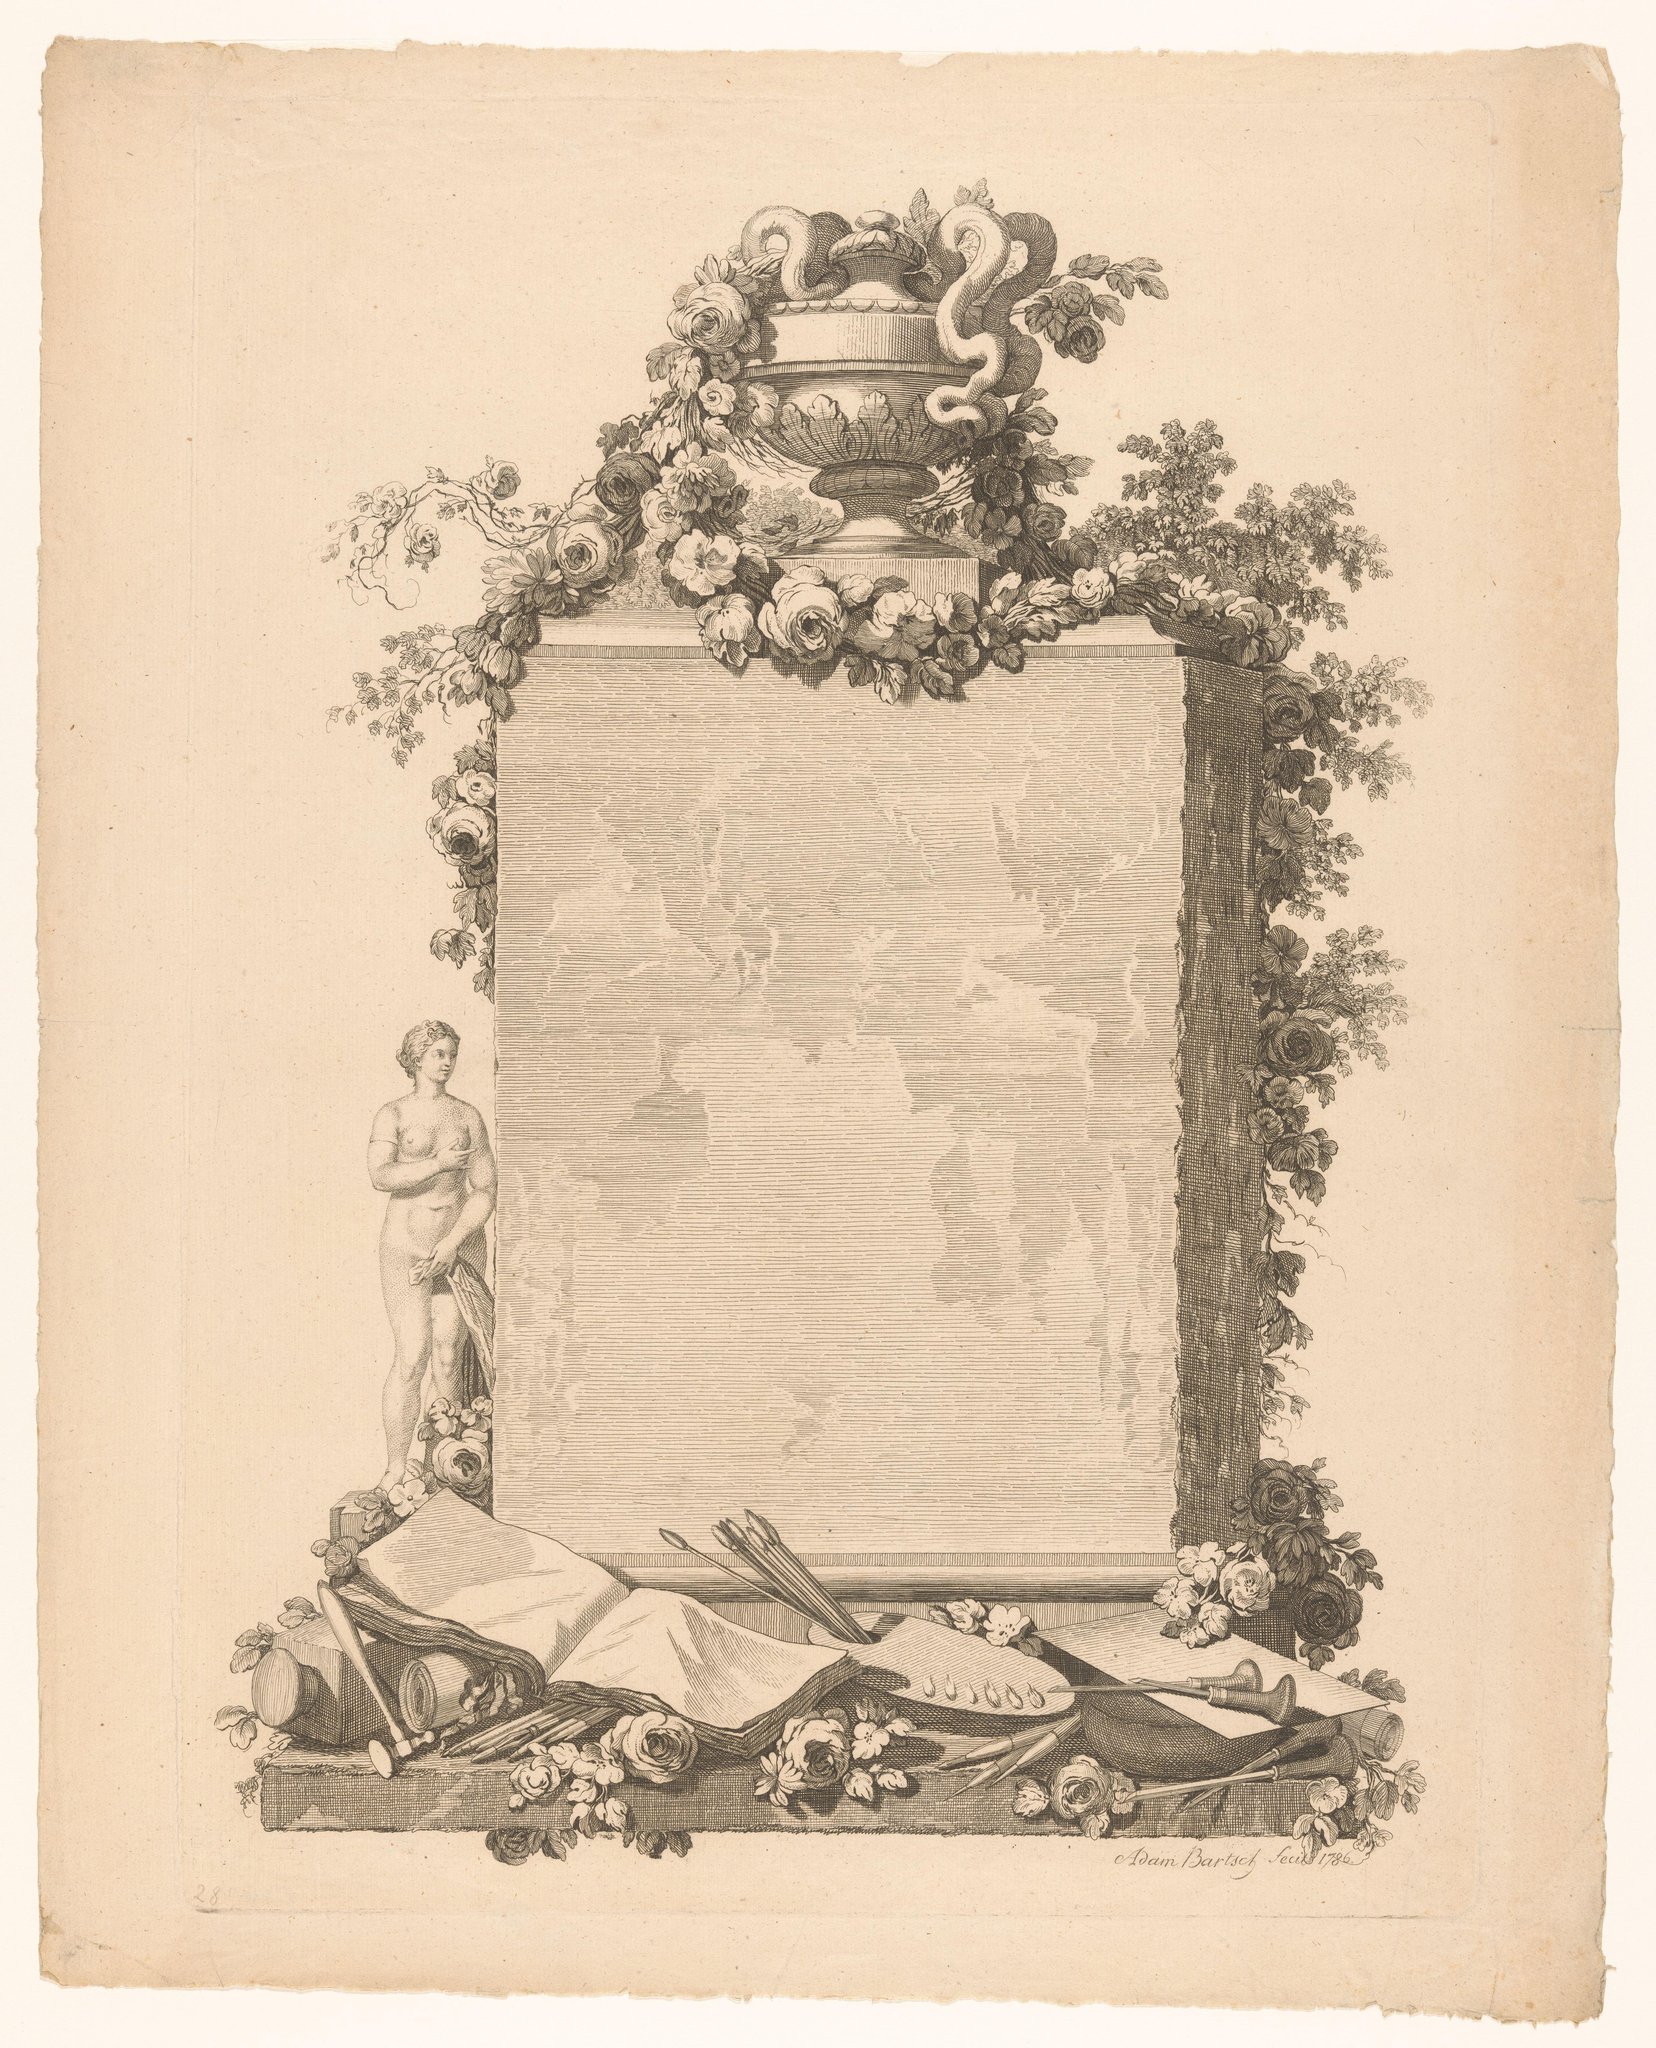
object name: titelprent, frontispice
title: Titelprent voor de verzamelbanden van de prentcollectie van de Weense Hofbibliotheek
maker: adam von bartsch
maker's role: print maker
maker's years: 1757-1821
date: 1786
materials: paper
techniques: etching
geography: vienna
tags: foliage, tendrils, branches ~ ornament - aa - stylized, vase ~ ornament, tools, implements of graphic artist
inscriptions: number: ‘15'77’, number: Lugt 2228, collector's mark: Lugt 2760, number: ‘28’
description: In het midden een grote sokkel bekroond met een vaas met bloemen. Onderaan liggen attributen voor teken-, schilder- en prentkunst, waaronder houders voor krijt, etsnaalden en burijnen.